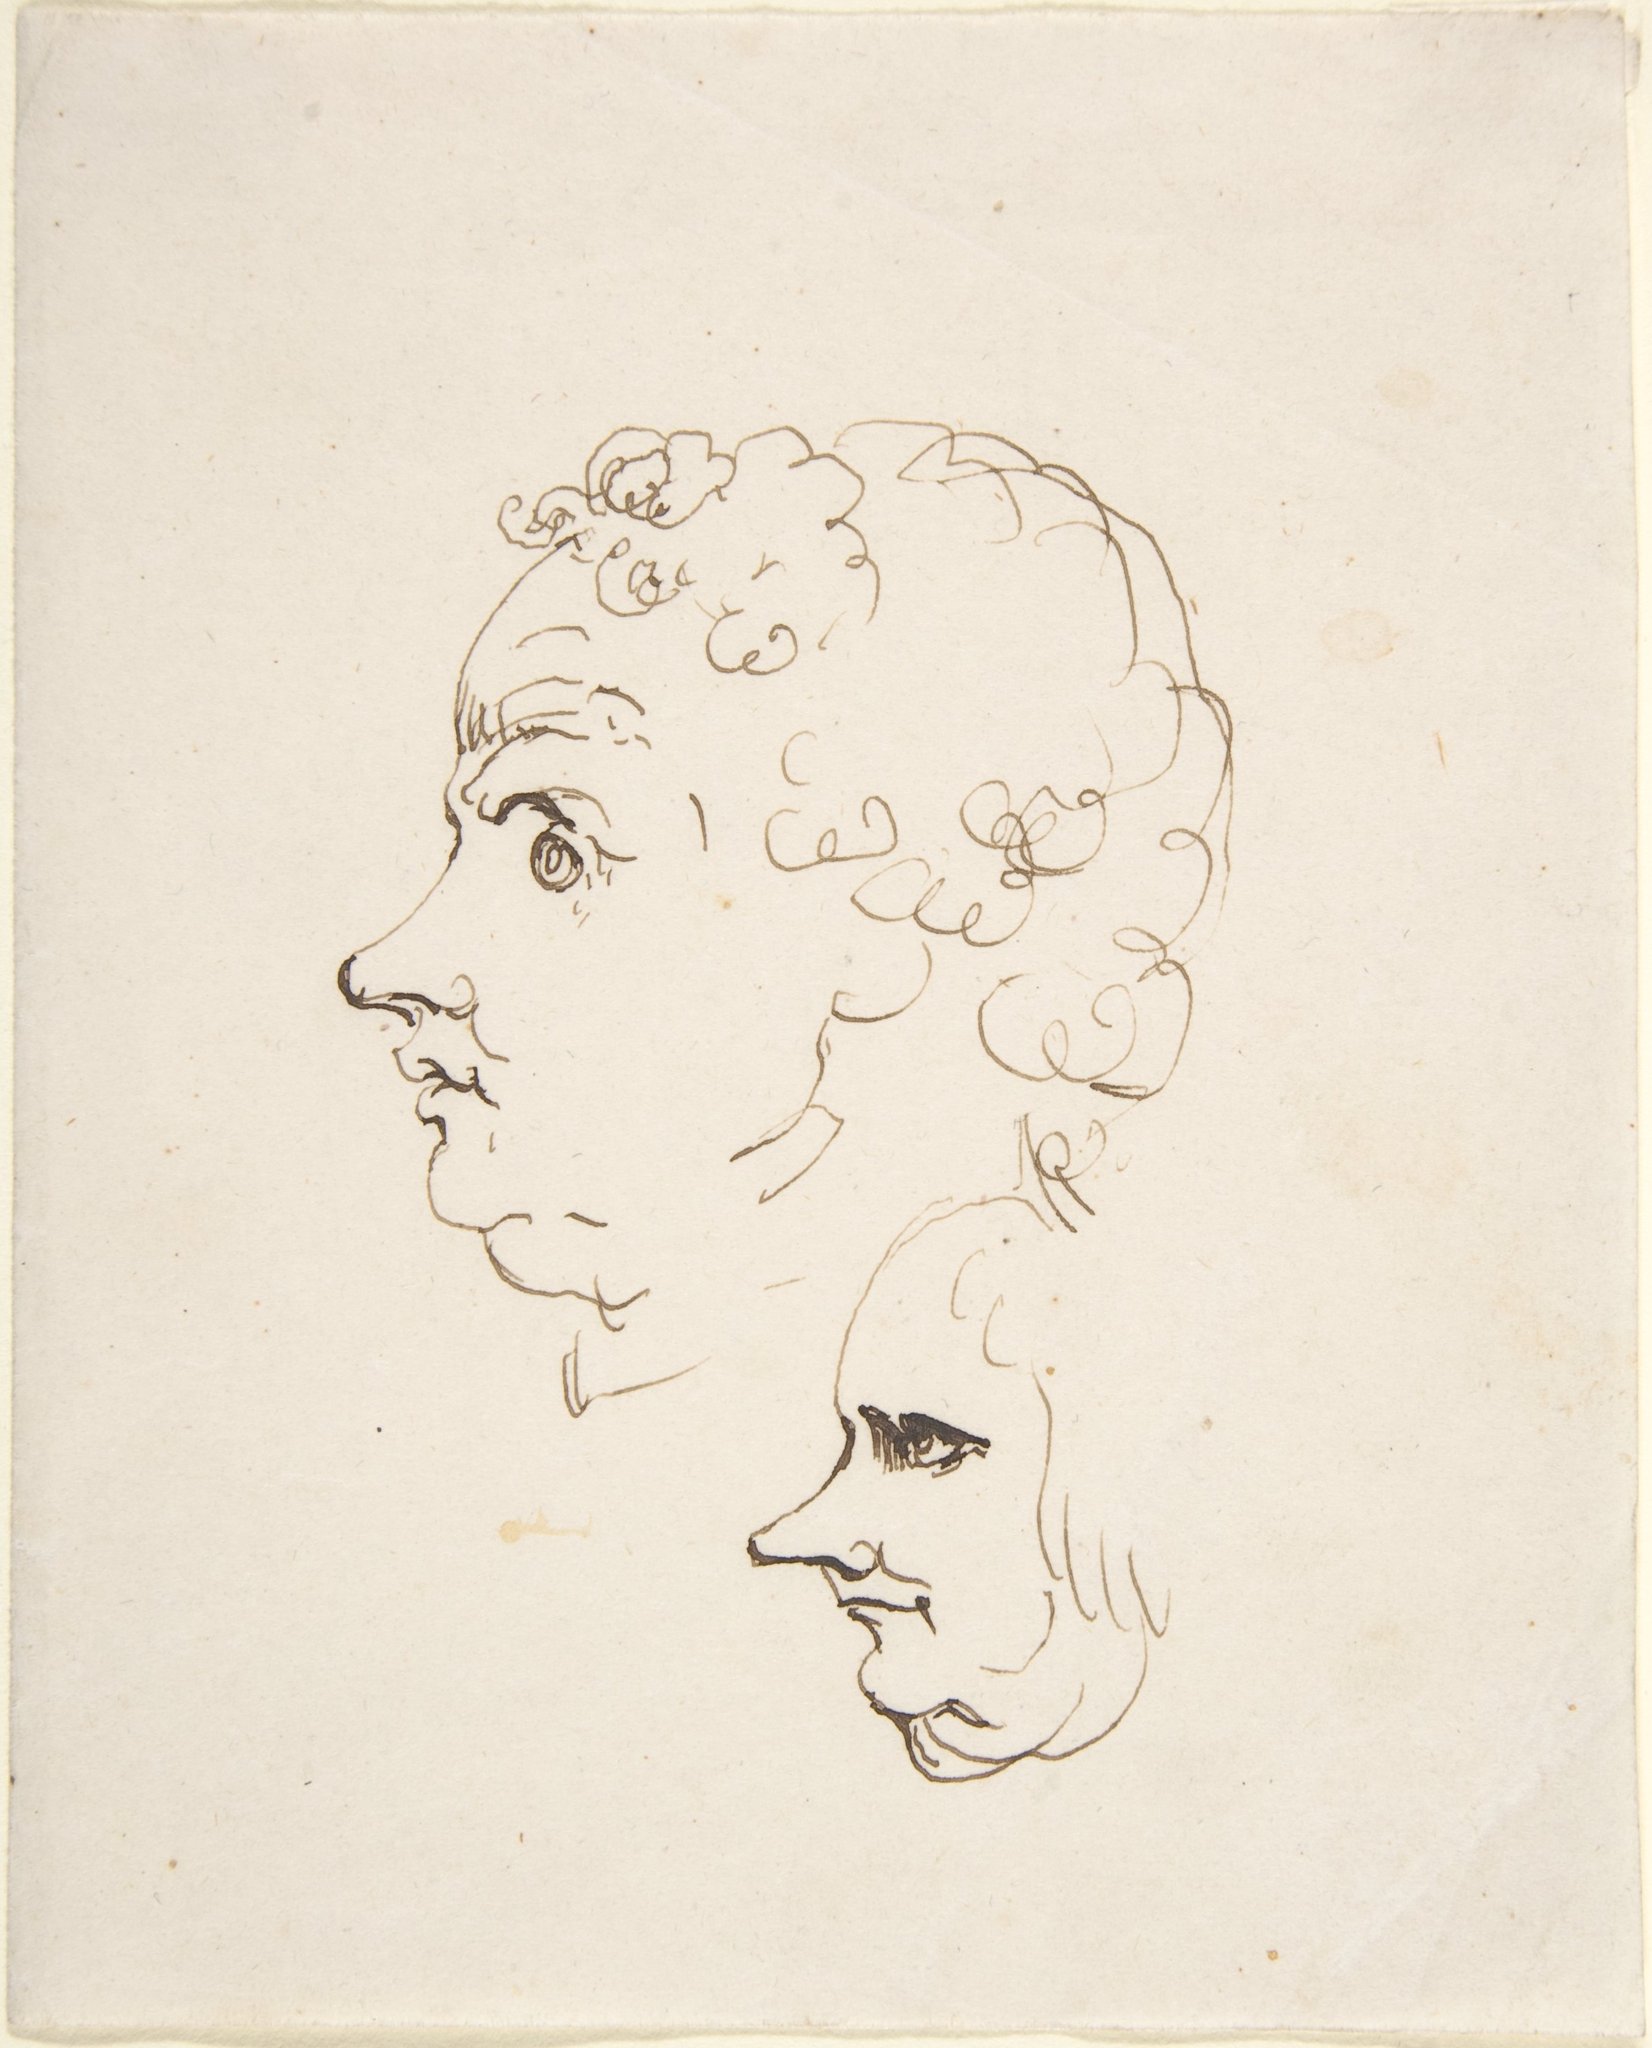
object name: drawing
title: Two Caricature Heads of Men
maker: johann heinrich wilhelm tischbein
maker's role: artist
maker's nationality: german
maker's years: 1751-1829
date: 1794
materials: ink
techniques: pen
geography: germany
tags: heads,men